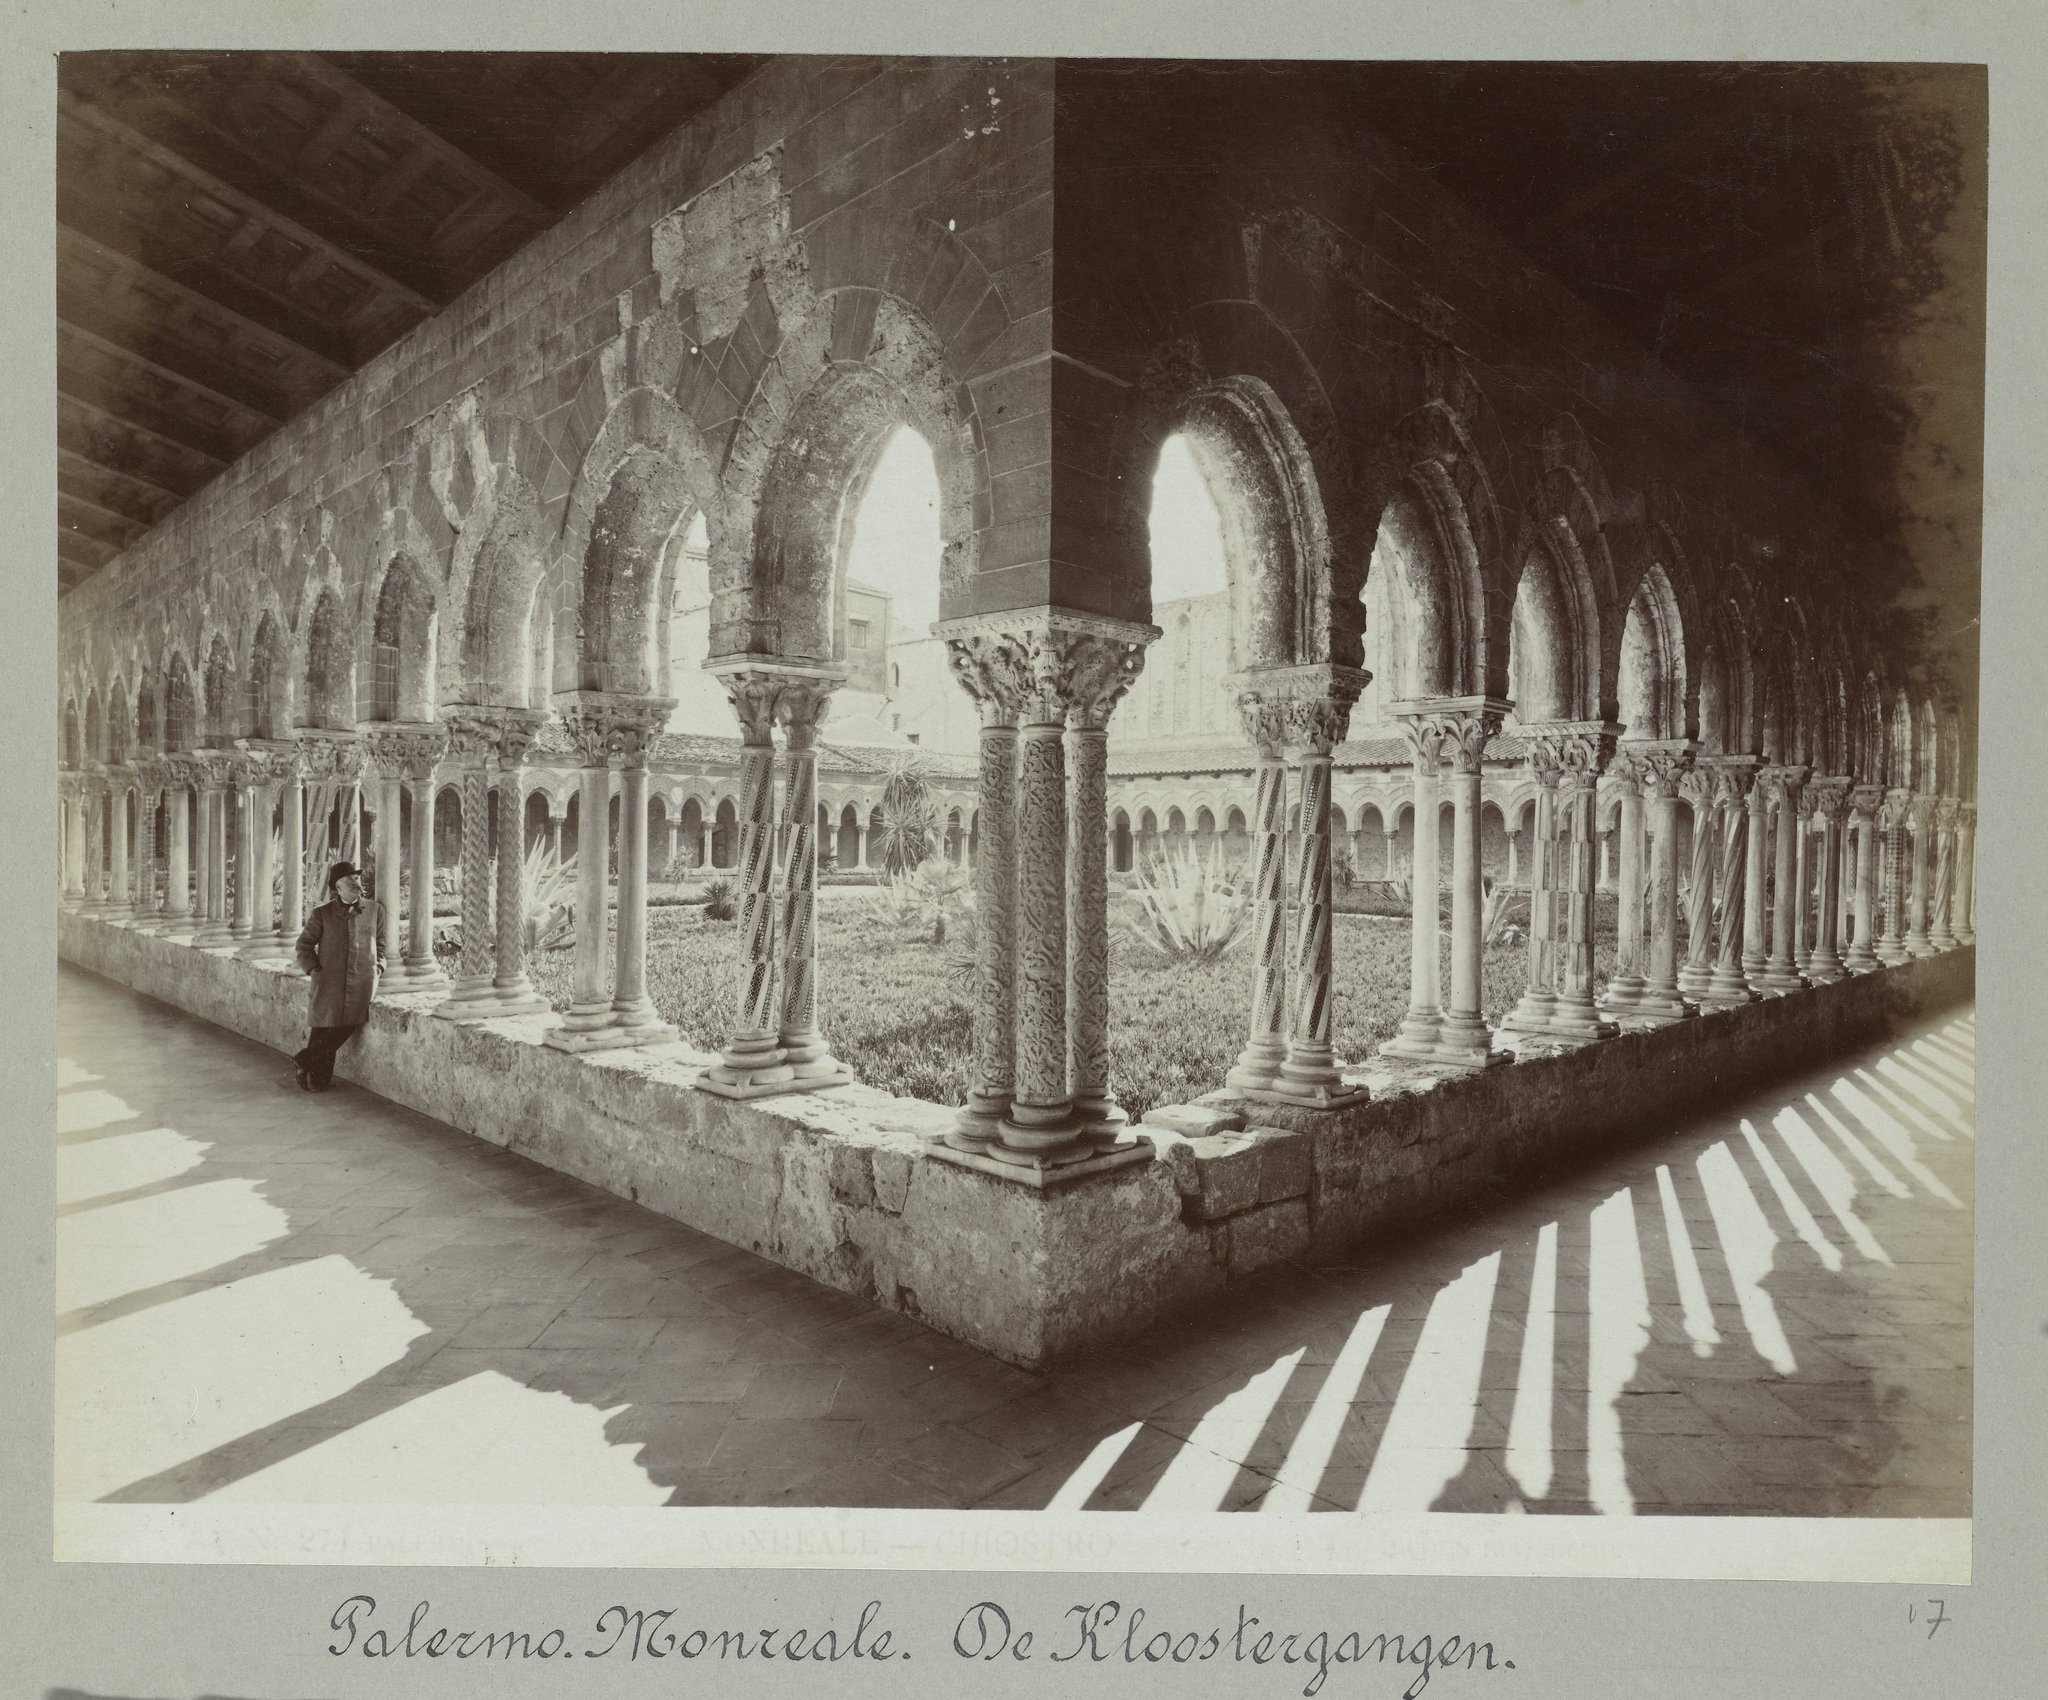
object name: photograph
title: Palermo Monreale. De kloostergangen.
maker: giuseppe incorpora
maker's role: fotograaf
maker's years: 1834-1914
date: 1893-1903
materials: cardboard, photographic support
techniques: albumen print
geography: netherlands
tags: palermo